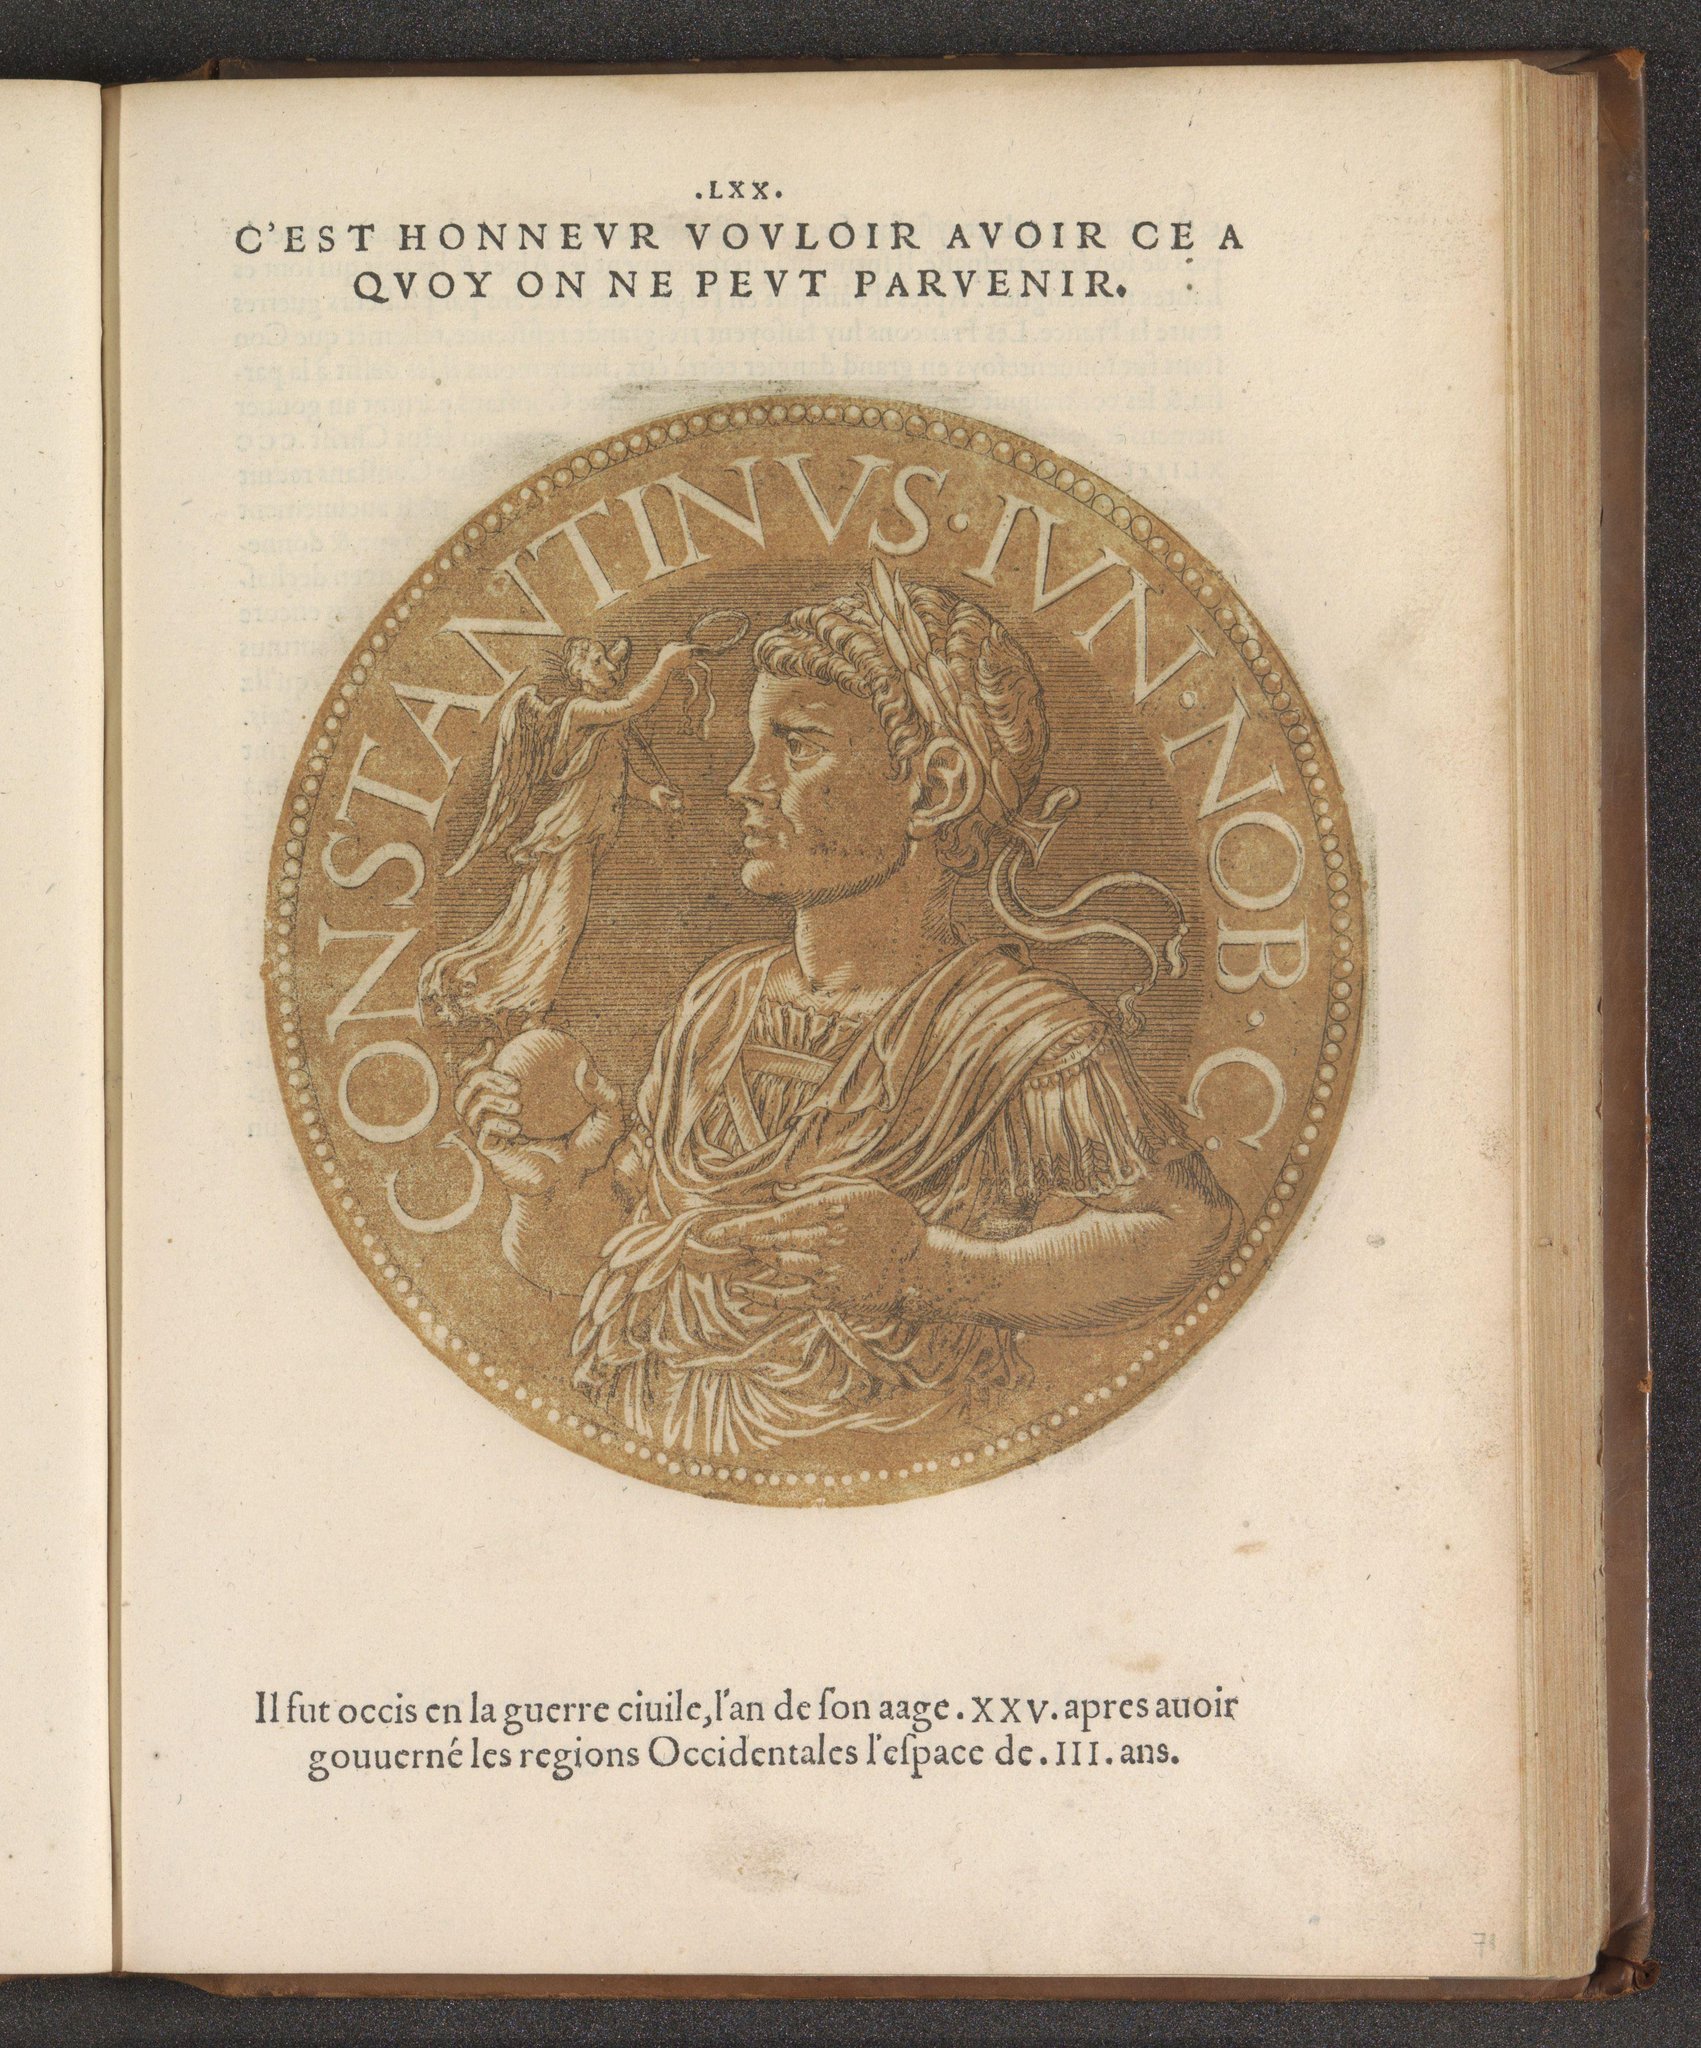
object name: page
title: Portret van keizer Constantijn II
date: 1557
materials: paper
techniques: woodcut, etching, letterpress printing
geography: antwerp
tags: victoria as roman personification, emperor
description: Portret van keizer Constantijn II, op een munt met randschrift. Naast het het portret een afbeelding van de godin Victoria. De prent maakt deel uit van een boek over de keizers vanaf Julius Caesar tot en met Karel V en zijn broer Ferdinand.